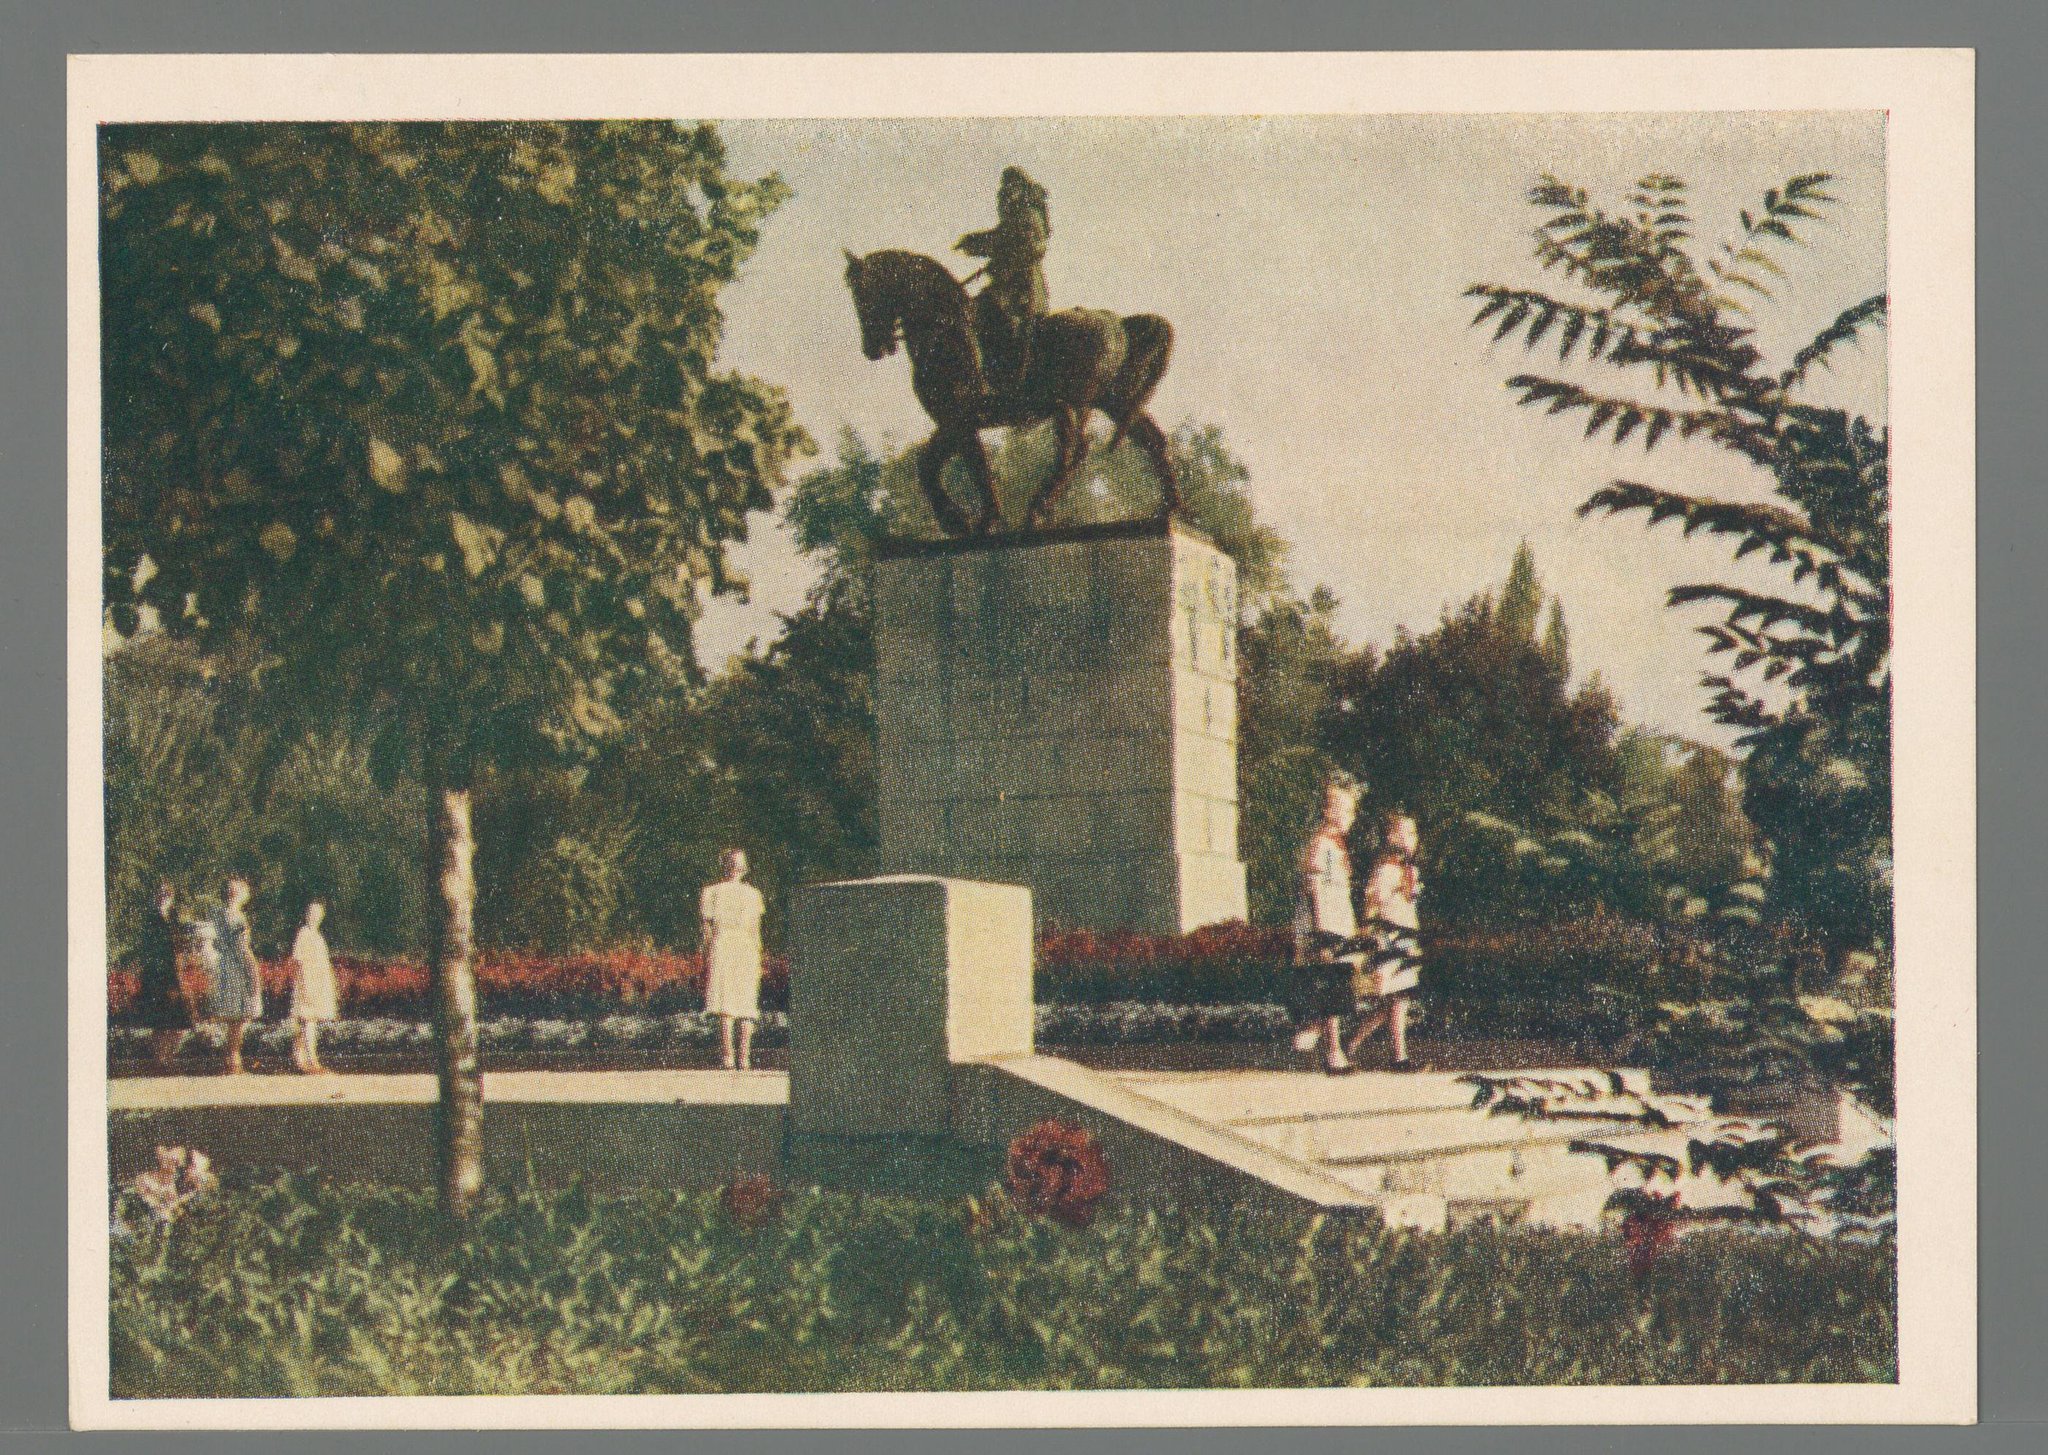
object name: ansichtkaart, prentbriefkaart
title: Kazakh S.S.R. Alma-Ata. Monument to Amangeldi Imanov / R.S.S. de Kazakhie. Alma-Ata. Monument à Amangeldy Imanov / Kasachische SSR. Alma-Ata. Denkmal Amangeldy Imanows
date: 1956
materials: cardboard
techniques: color autotype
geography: alma-ata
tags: monument, statue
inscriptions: date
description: De titel op object staat ook in het Russisch.